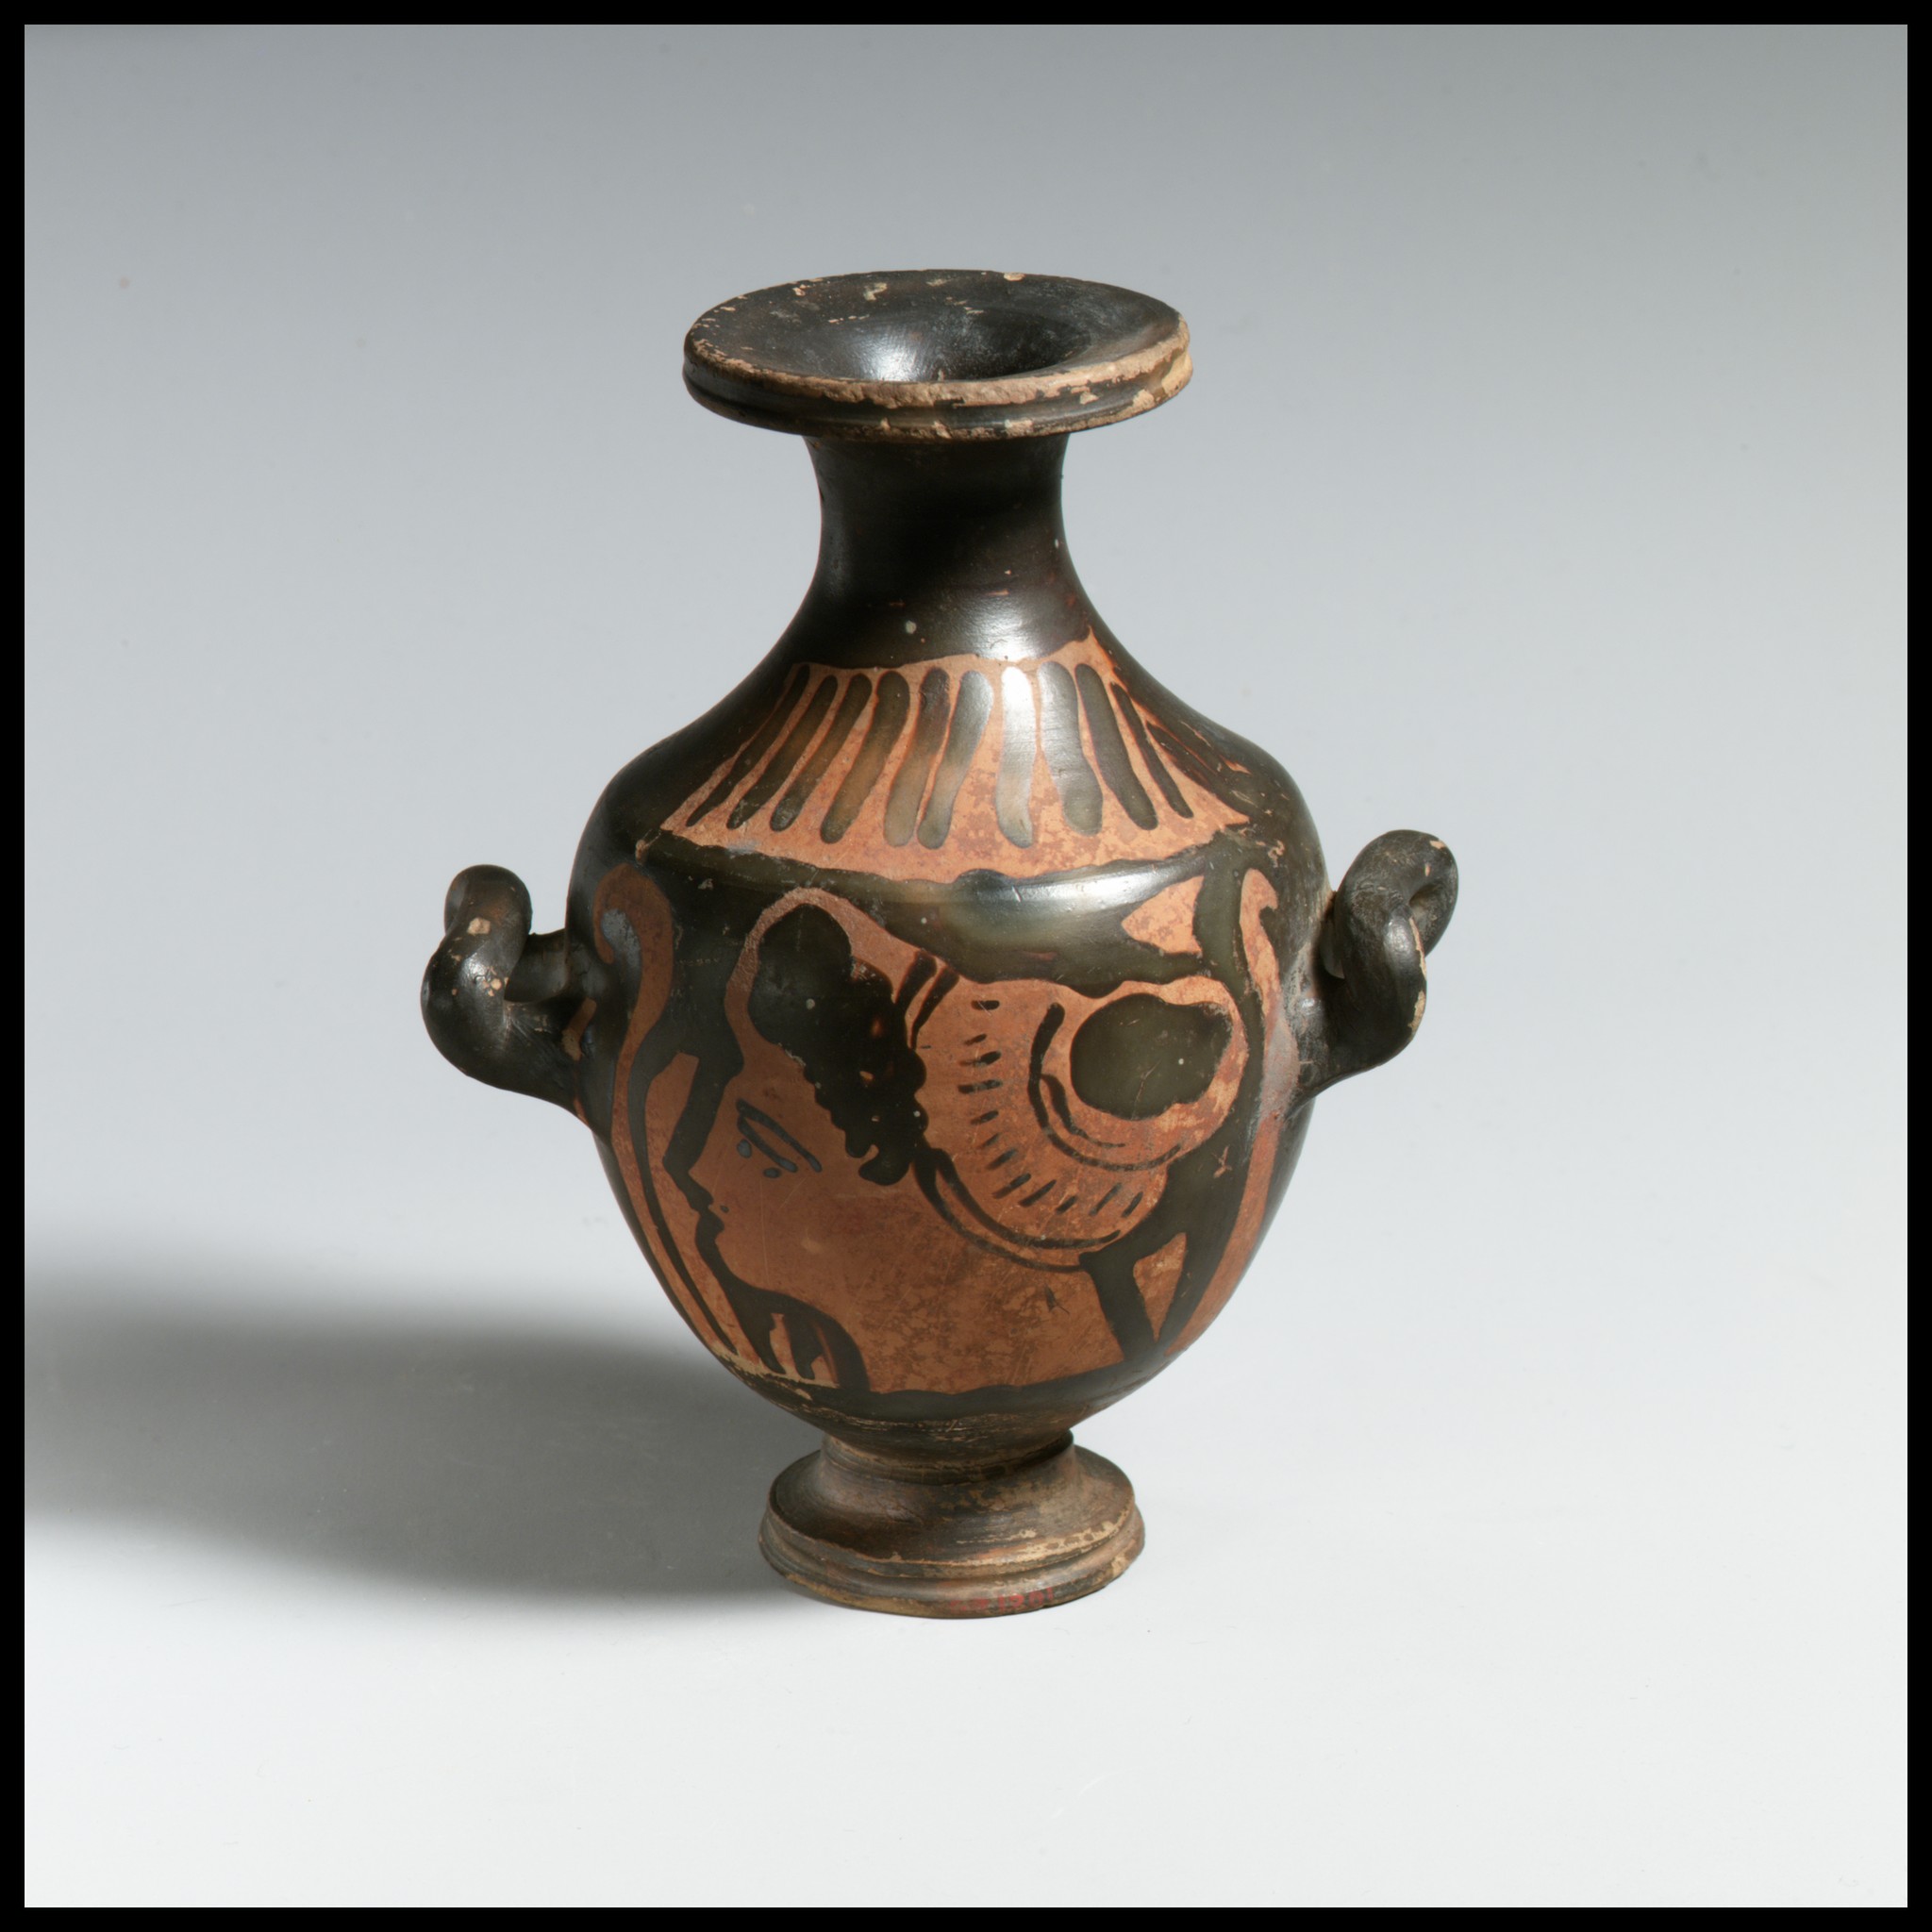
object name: hydria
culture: greek, south italian, apulian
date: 350-325 BCE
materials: terracotta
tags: heads,women